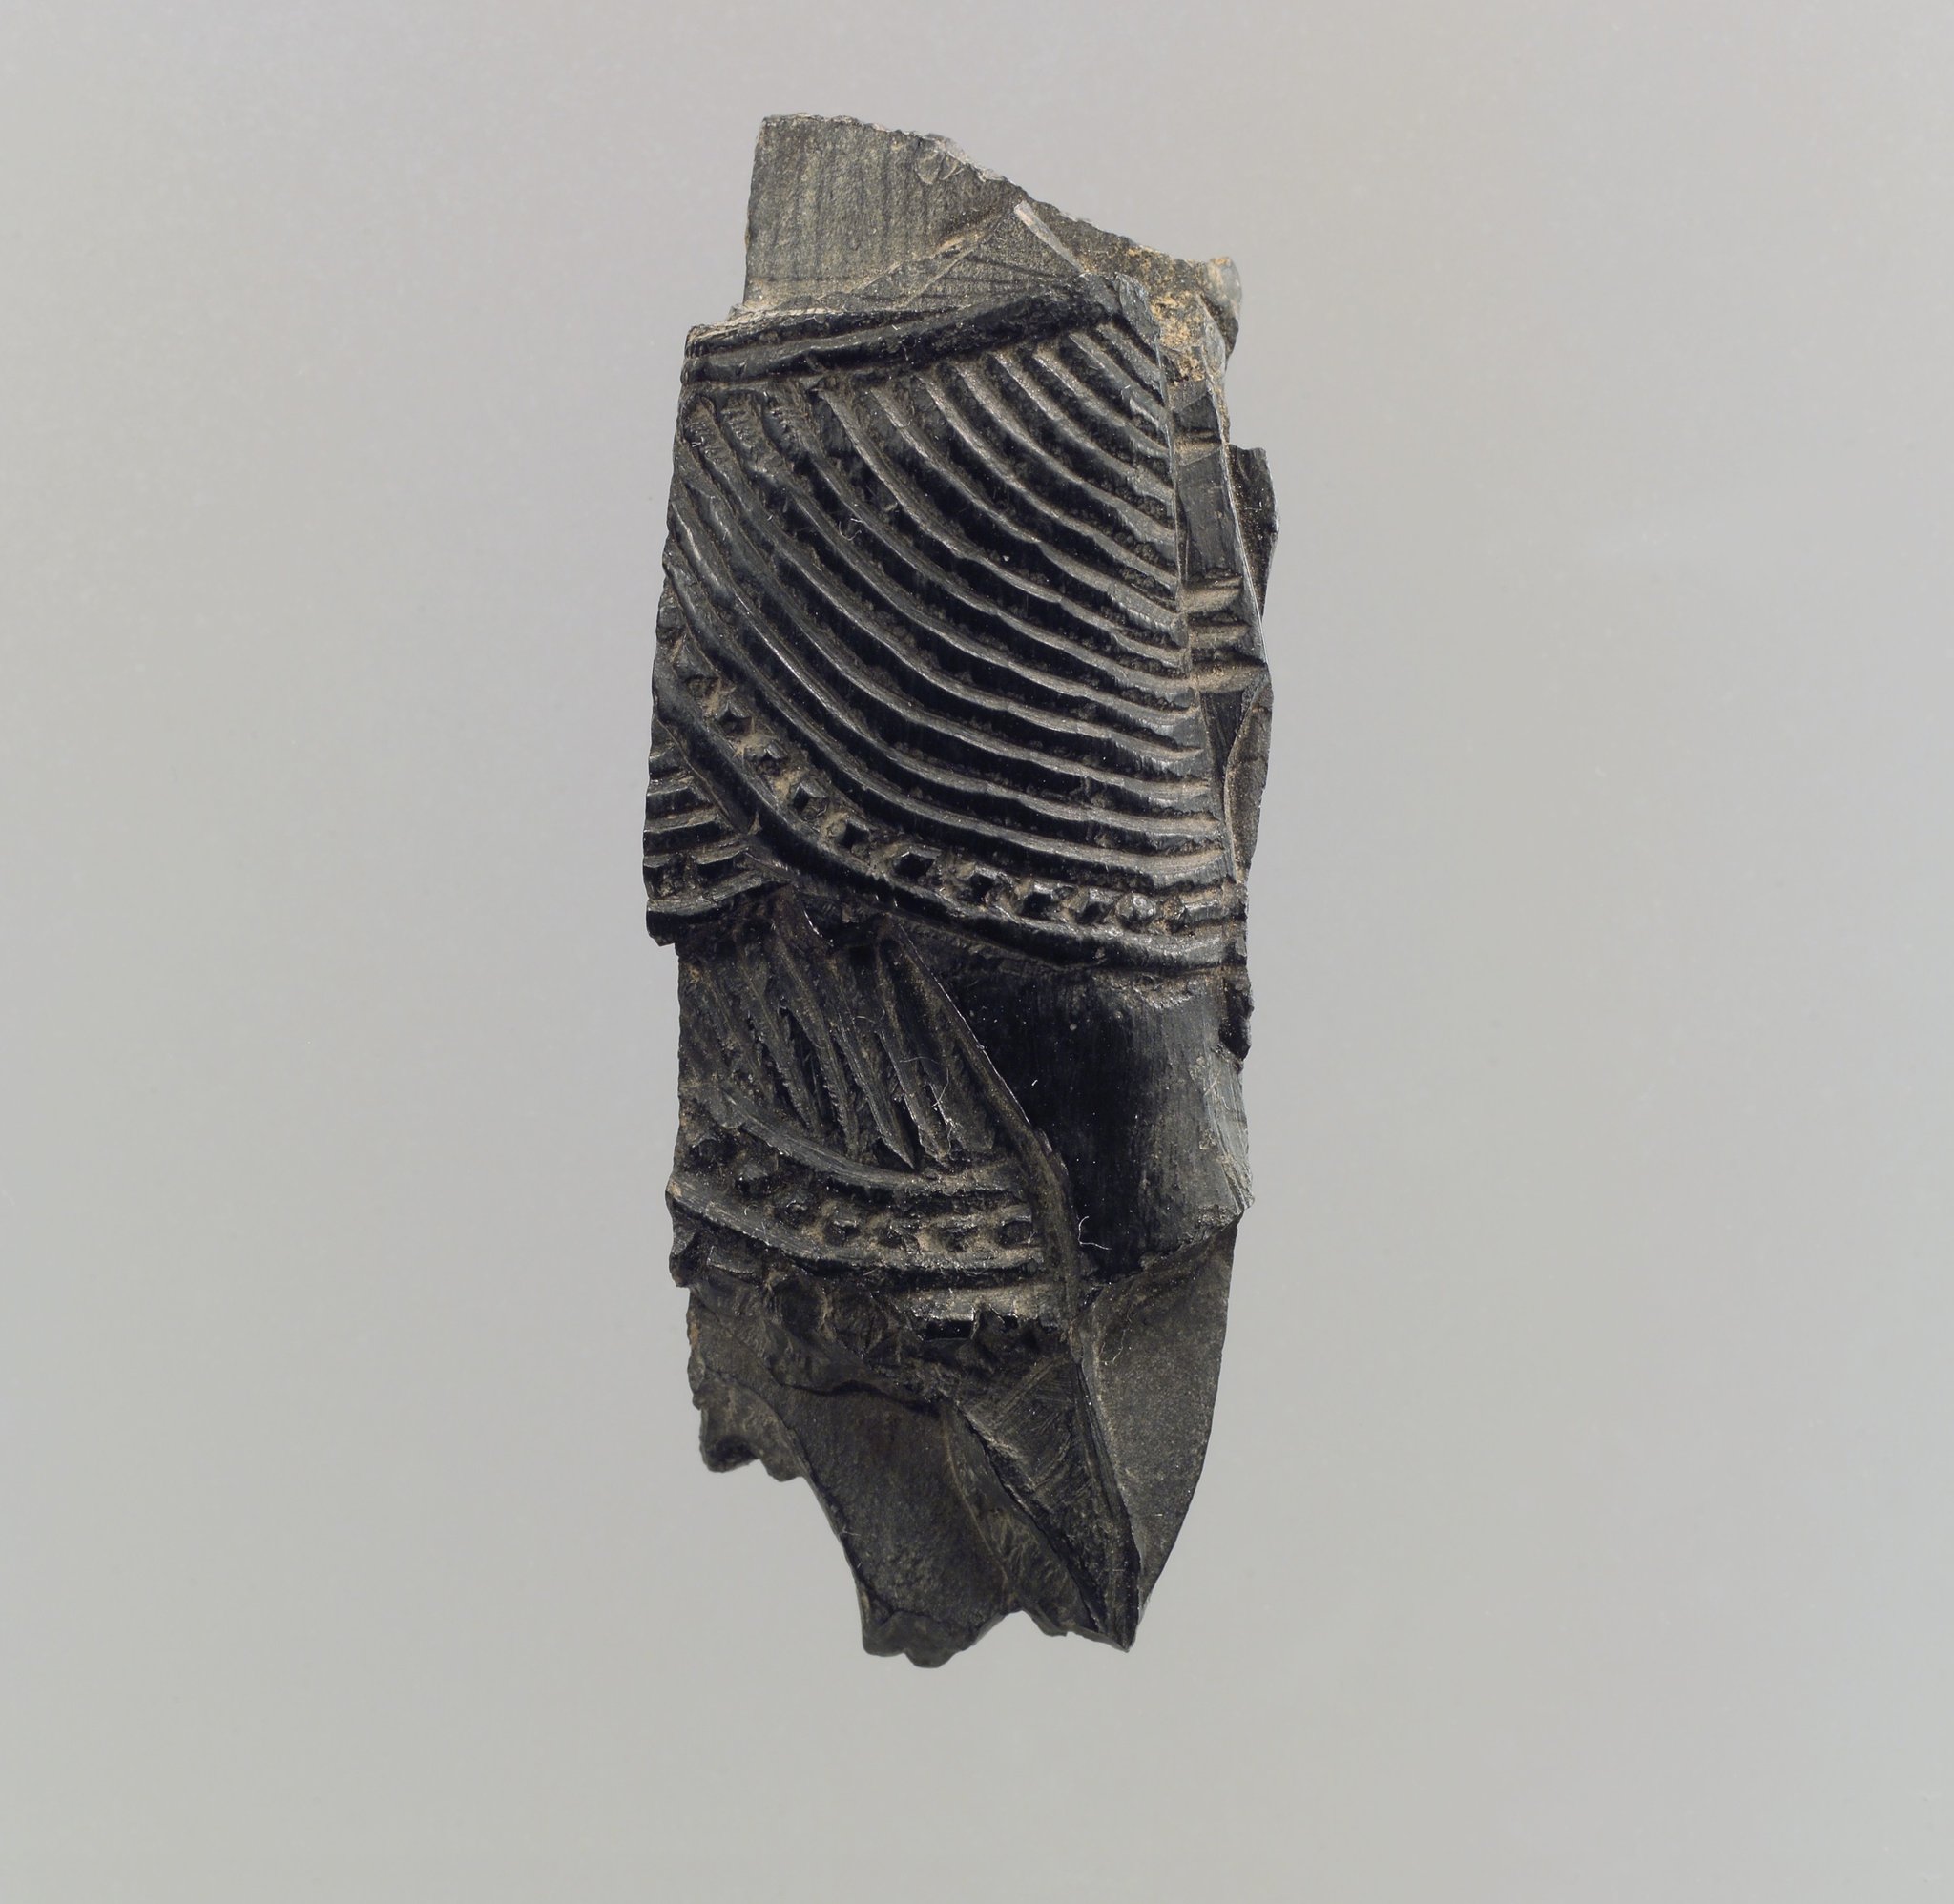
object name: relief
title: Plaque fragment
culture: assyrian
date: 800-601 BCE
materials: ivory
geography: mesopotamia